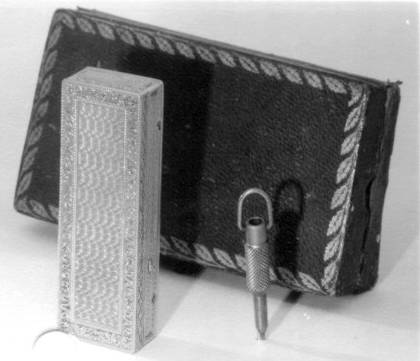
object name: music box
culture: swiss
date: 1810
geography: switzerland